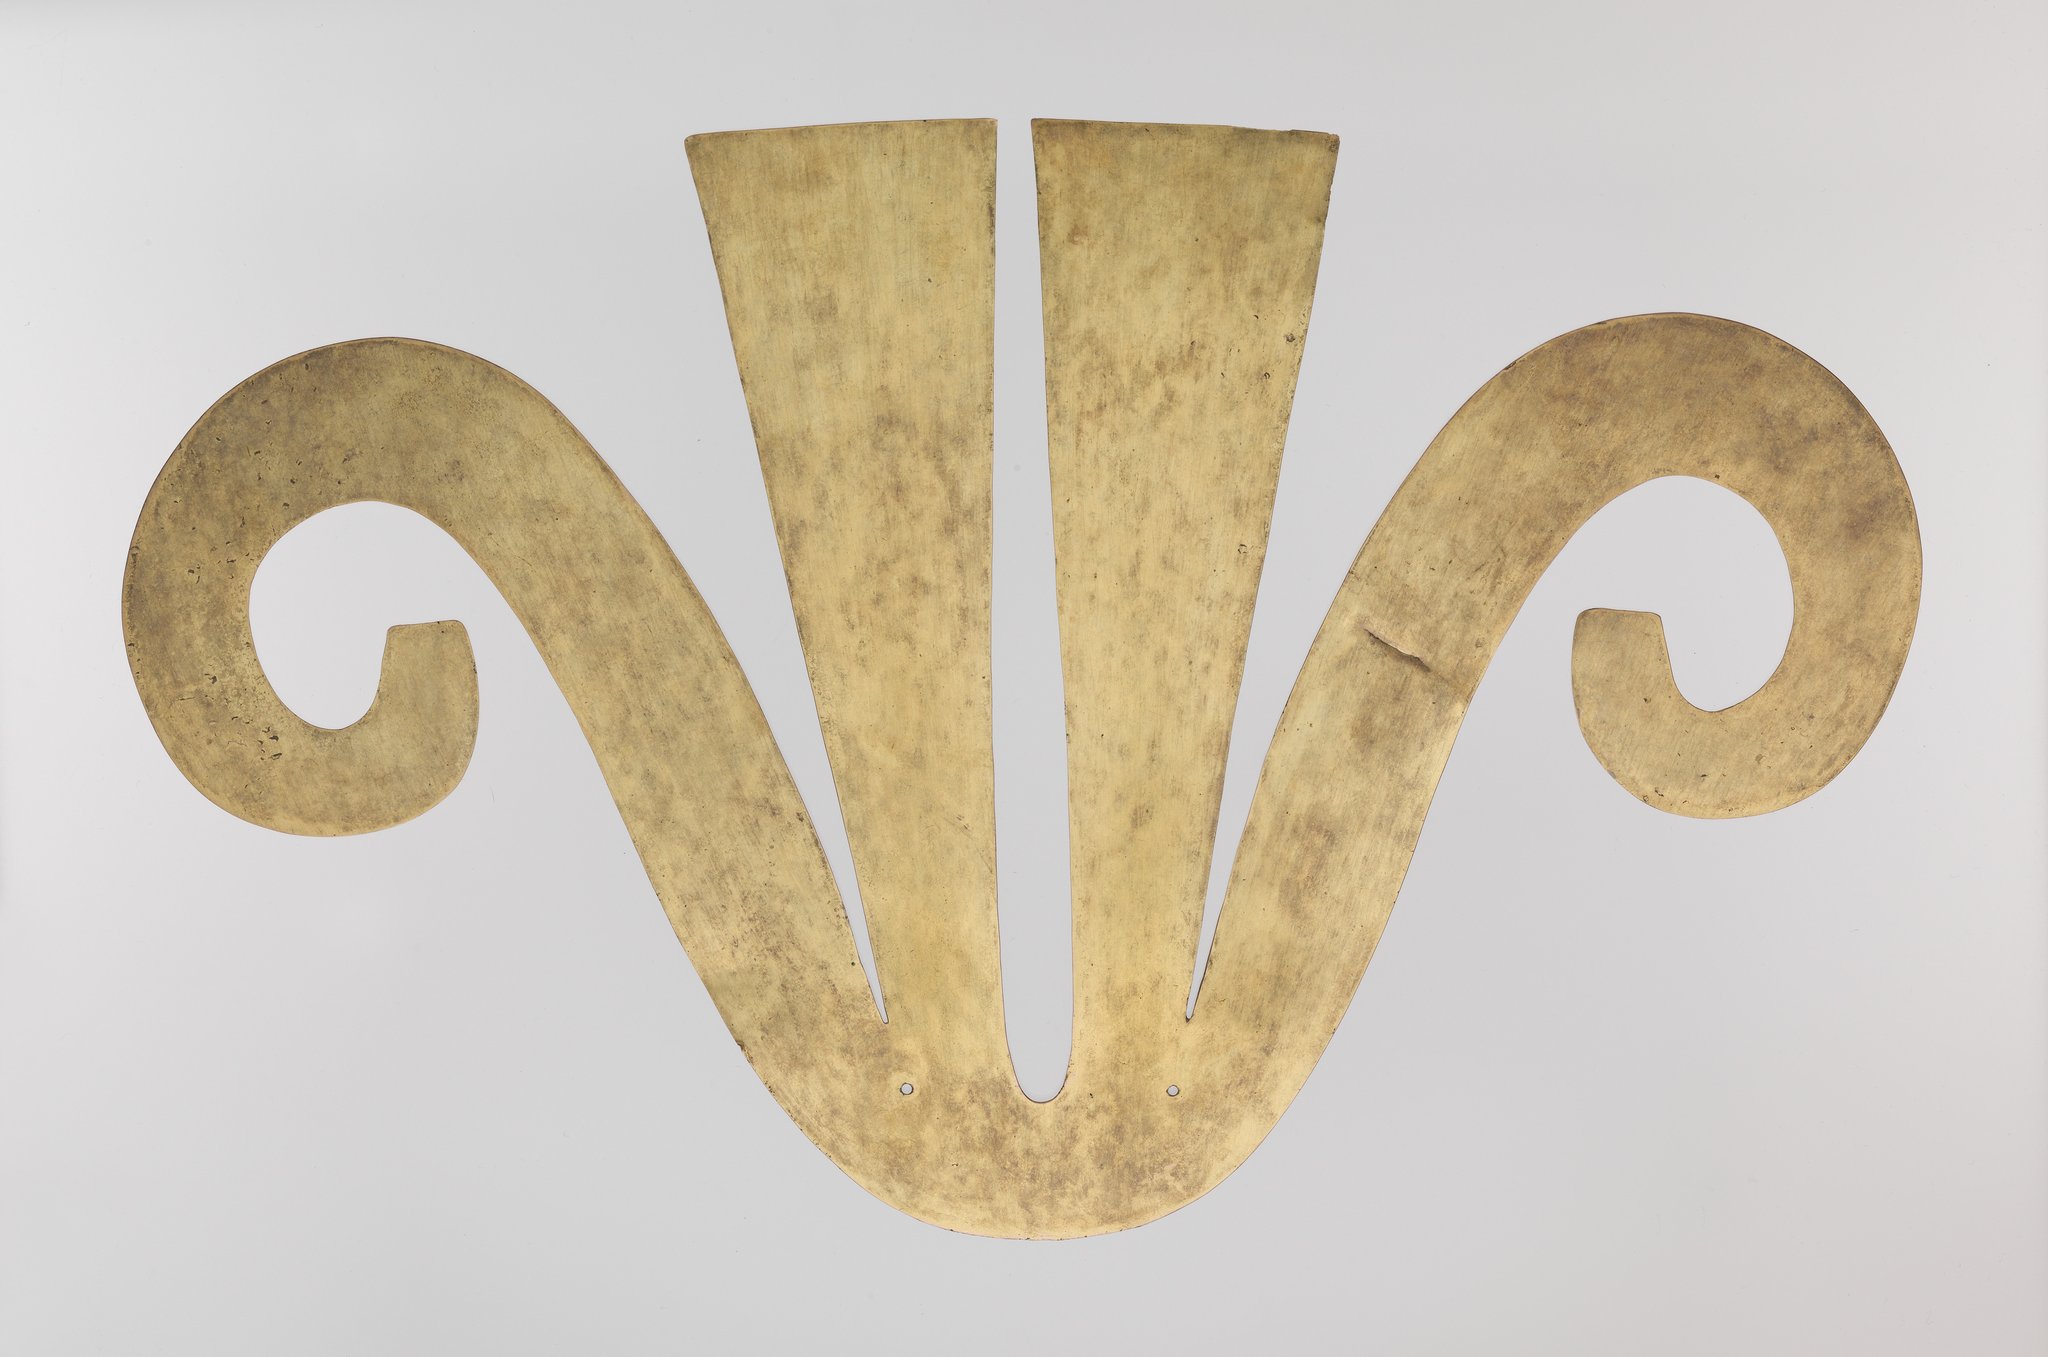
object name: ornament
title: Headdress Ornament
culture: piartal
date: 601-1200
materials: alloy, gold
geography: colombia